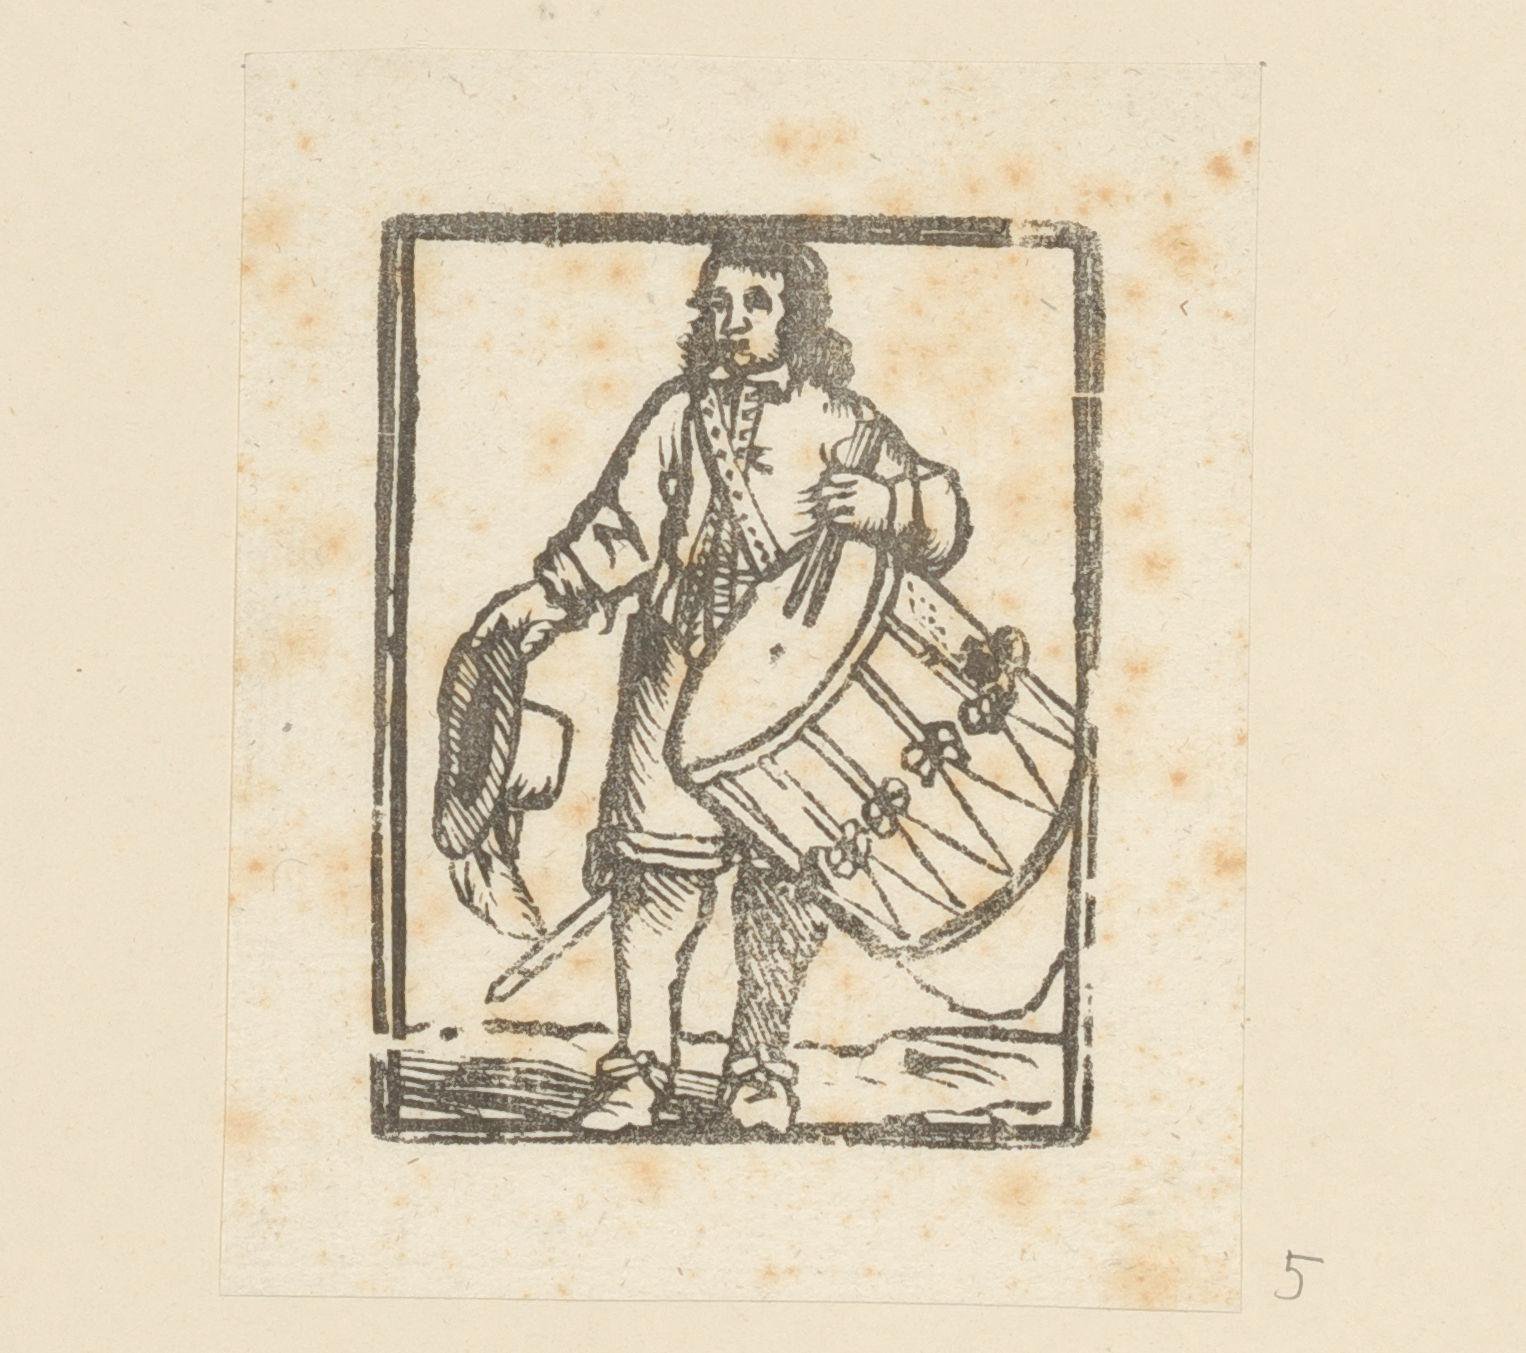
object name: print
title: Man met grote trom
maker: Anonymous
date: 1778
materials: paper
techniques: woodcut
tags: tambourine (+ artist at work), drum (musical instrument)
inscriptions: collector's mark: Lugt 1641, stamp, stamp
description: Onderwerpsrubrieken binnen de Atlas Zeden en Gewoonten: Onderwijs en Wetenschappen, Opvoeding en Onderwijs, Haneboeken en schoolprenten.